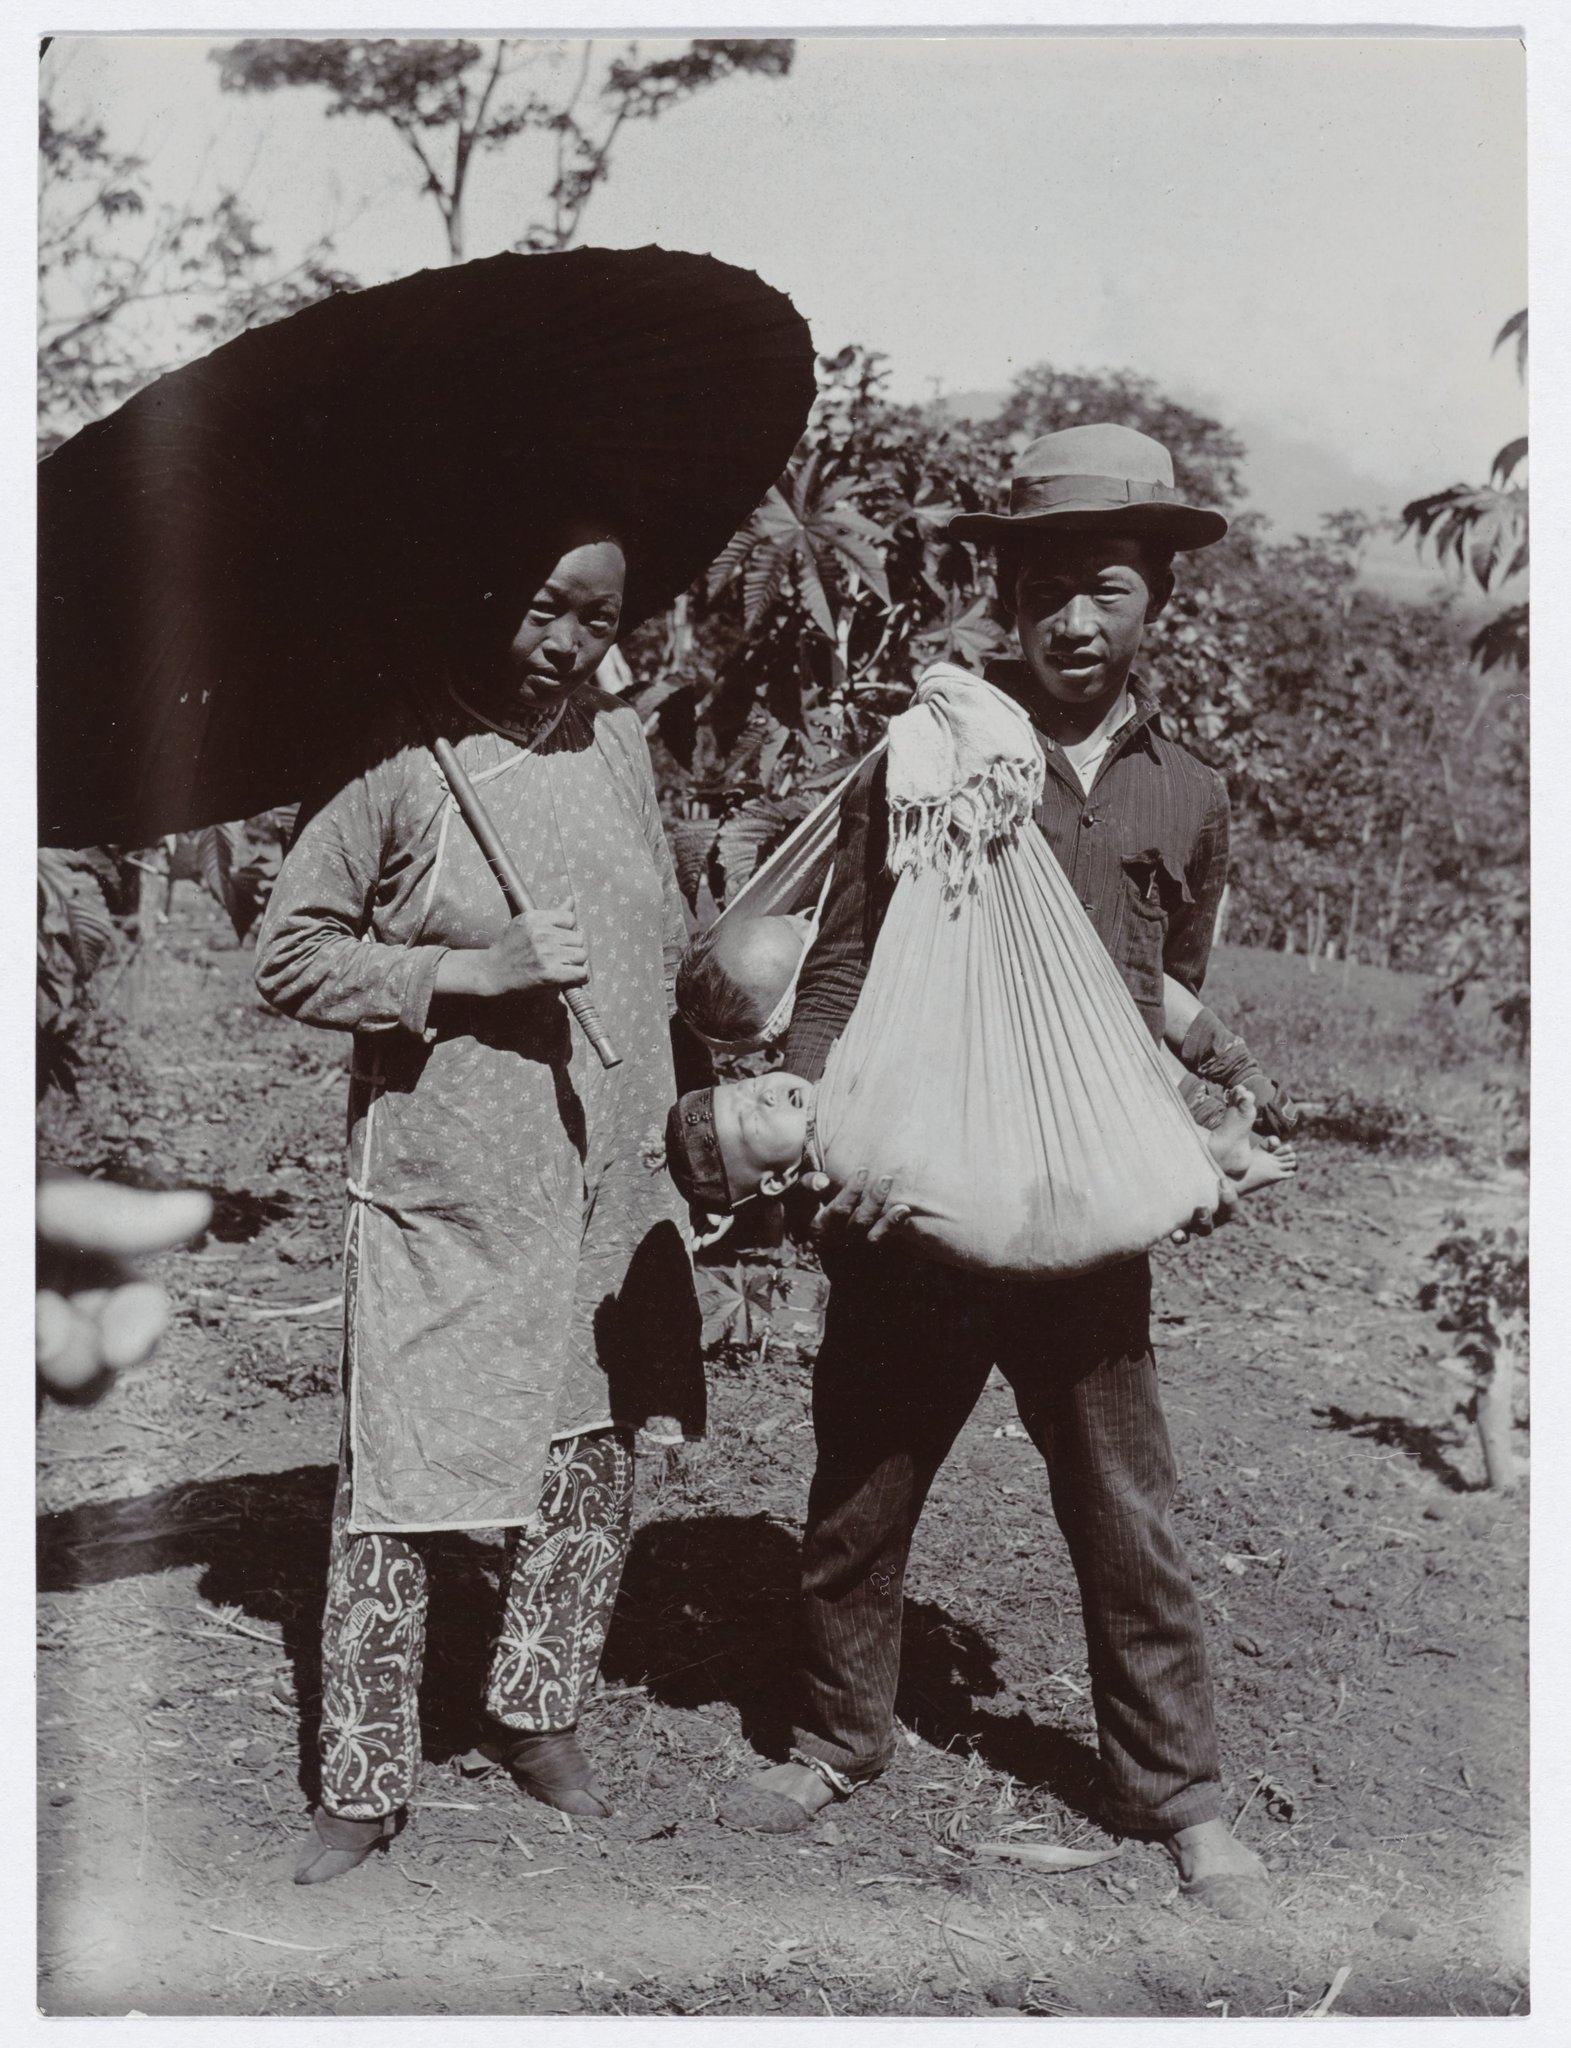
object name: photograph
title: Een Chinese familie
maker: johanna hermina marmelstein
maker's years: 1897-1990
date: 1900-1915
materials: paper, photographic support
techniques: albumen print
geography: jakarta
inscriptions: annotation: ‘16. Midden Bali. Chineesche (echte Singke's) familie door Bali trekkend. Let op de voeten der vrouw.’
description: Een Chinese familie bestaande uit een man, een vrouw en twee baby's. De vrouw draagt een Chinese overjas en een parasol, haar voeten zijn afgebonden. De man heeft een draagzak met de baby's, een hangt voor en een hangt achter.